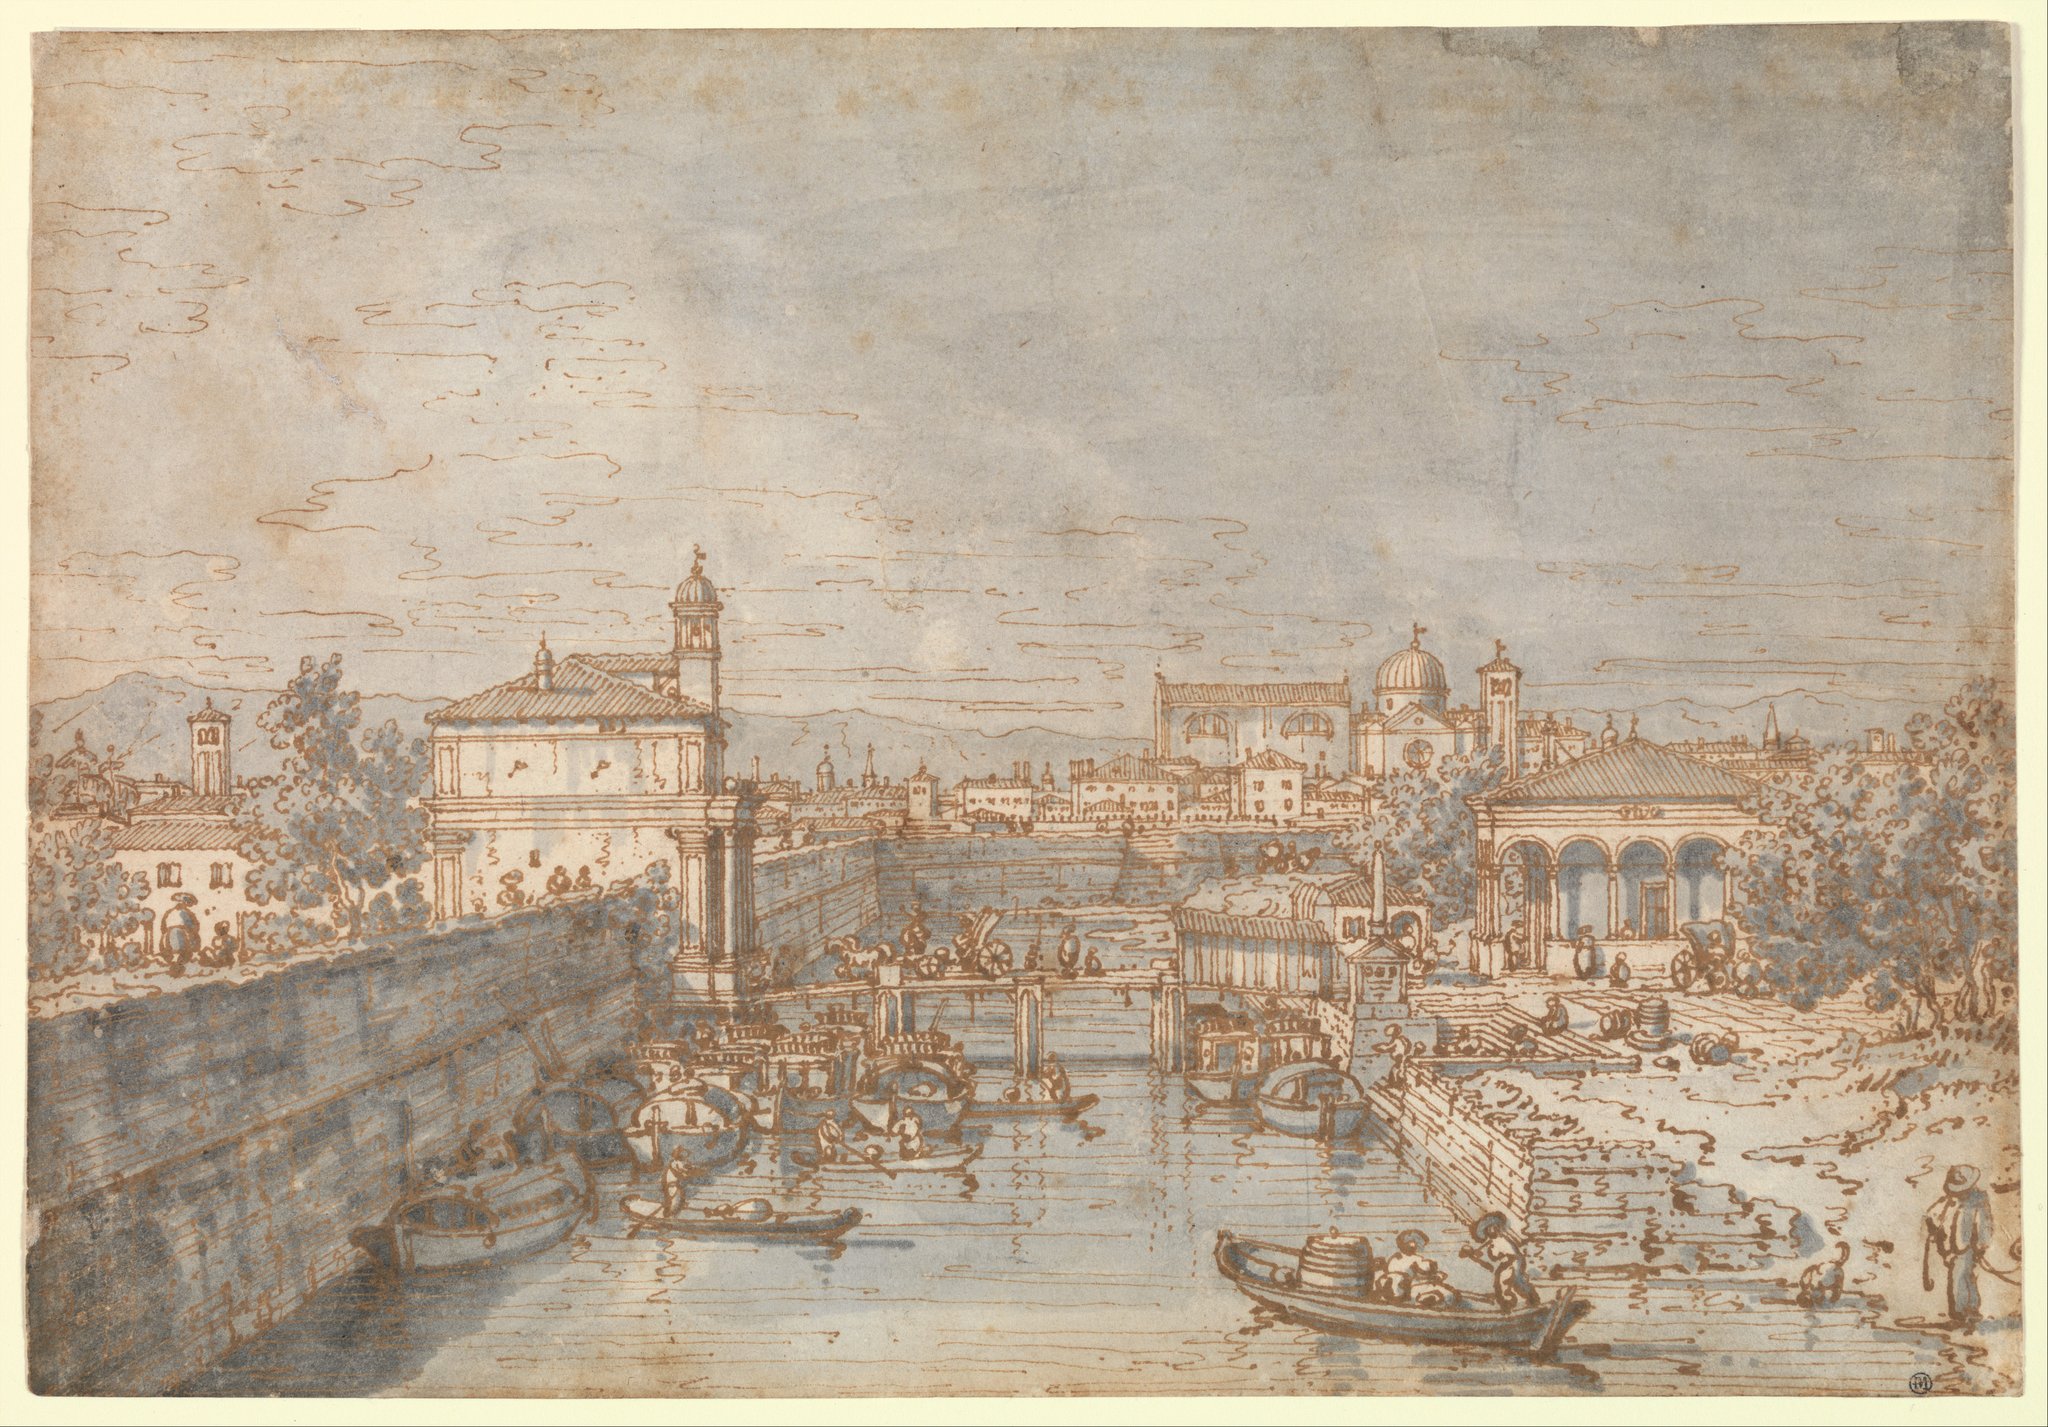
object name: drawing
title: Padua: The River Bacchiglione and the Porta Portello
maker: canaletto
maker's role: artist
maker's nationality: italian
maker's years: 1697-1768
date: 1750-1760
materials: ink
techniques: pen, wash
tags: bridges,rivers,boats,venice